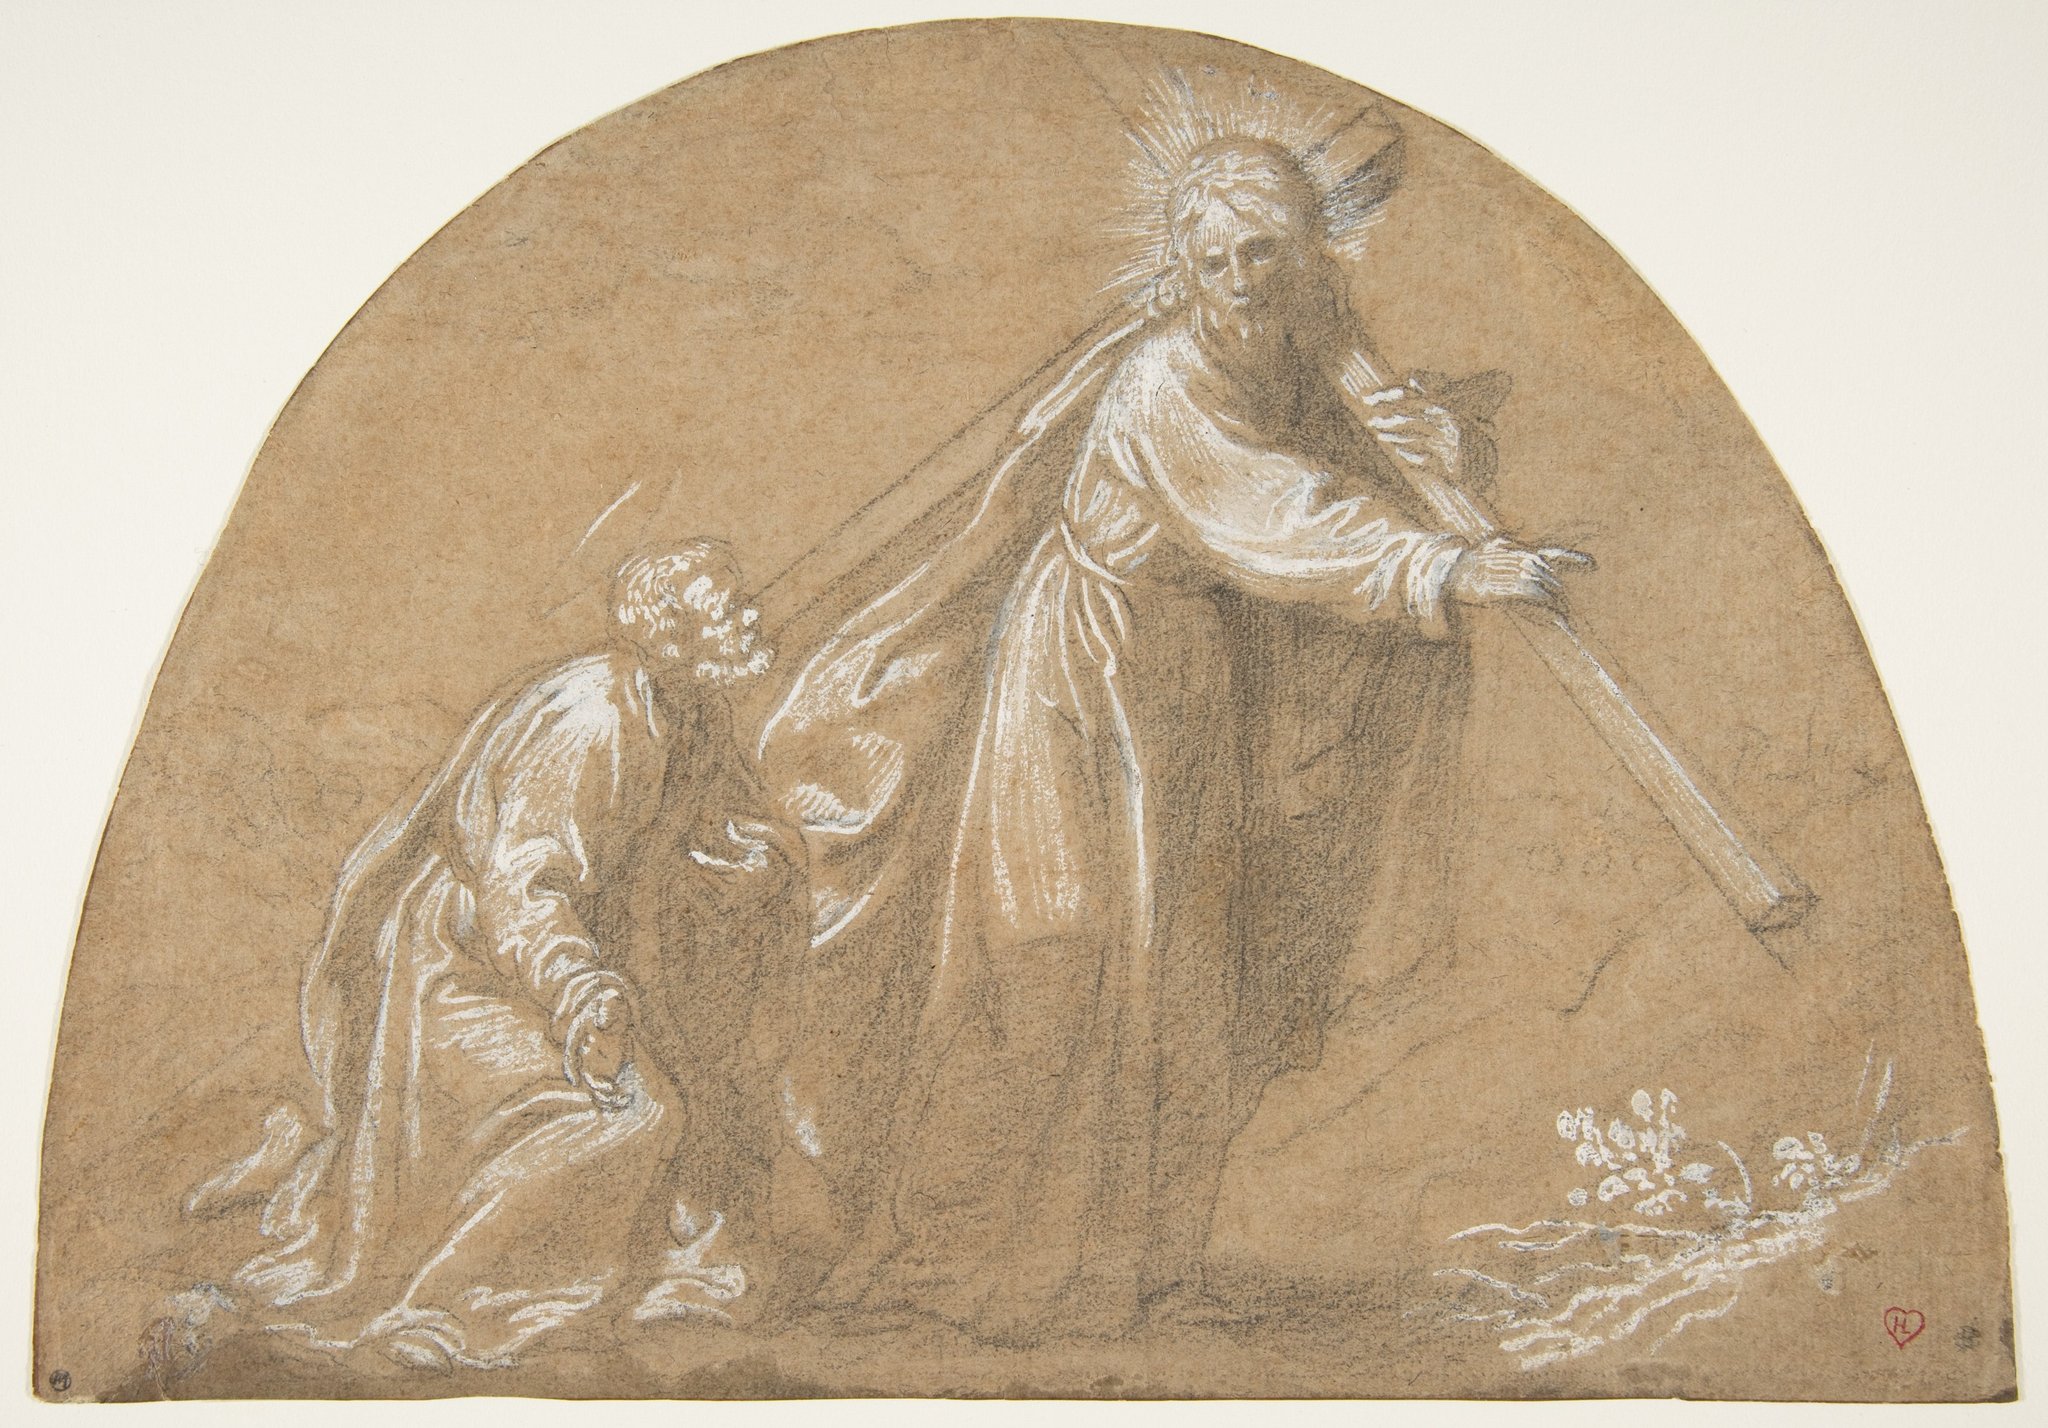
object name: drawing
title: Domine, Quo Vadis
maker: jacopo vignali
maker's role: artist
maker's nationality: italian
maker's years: 1592-1664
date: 1592-1664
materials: chalk, paper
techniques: highlighting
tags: cross